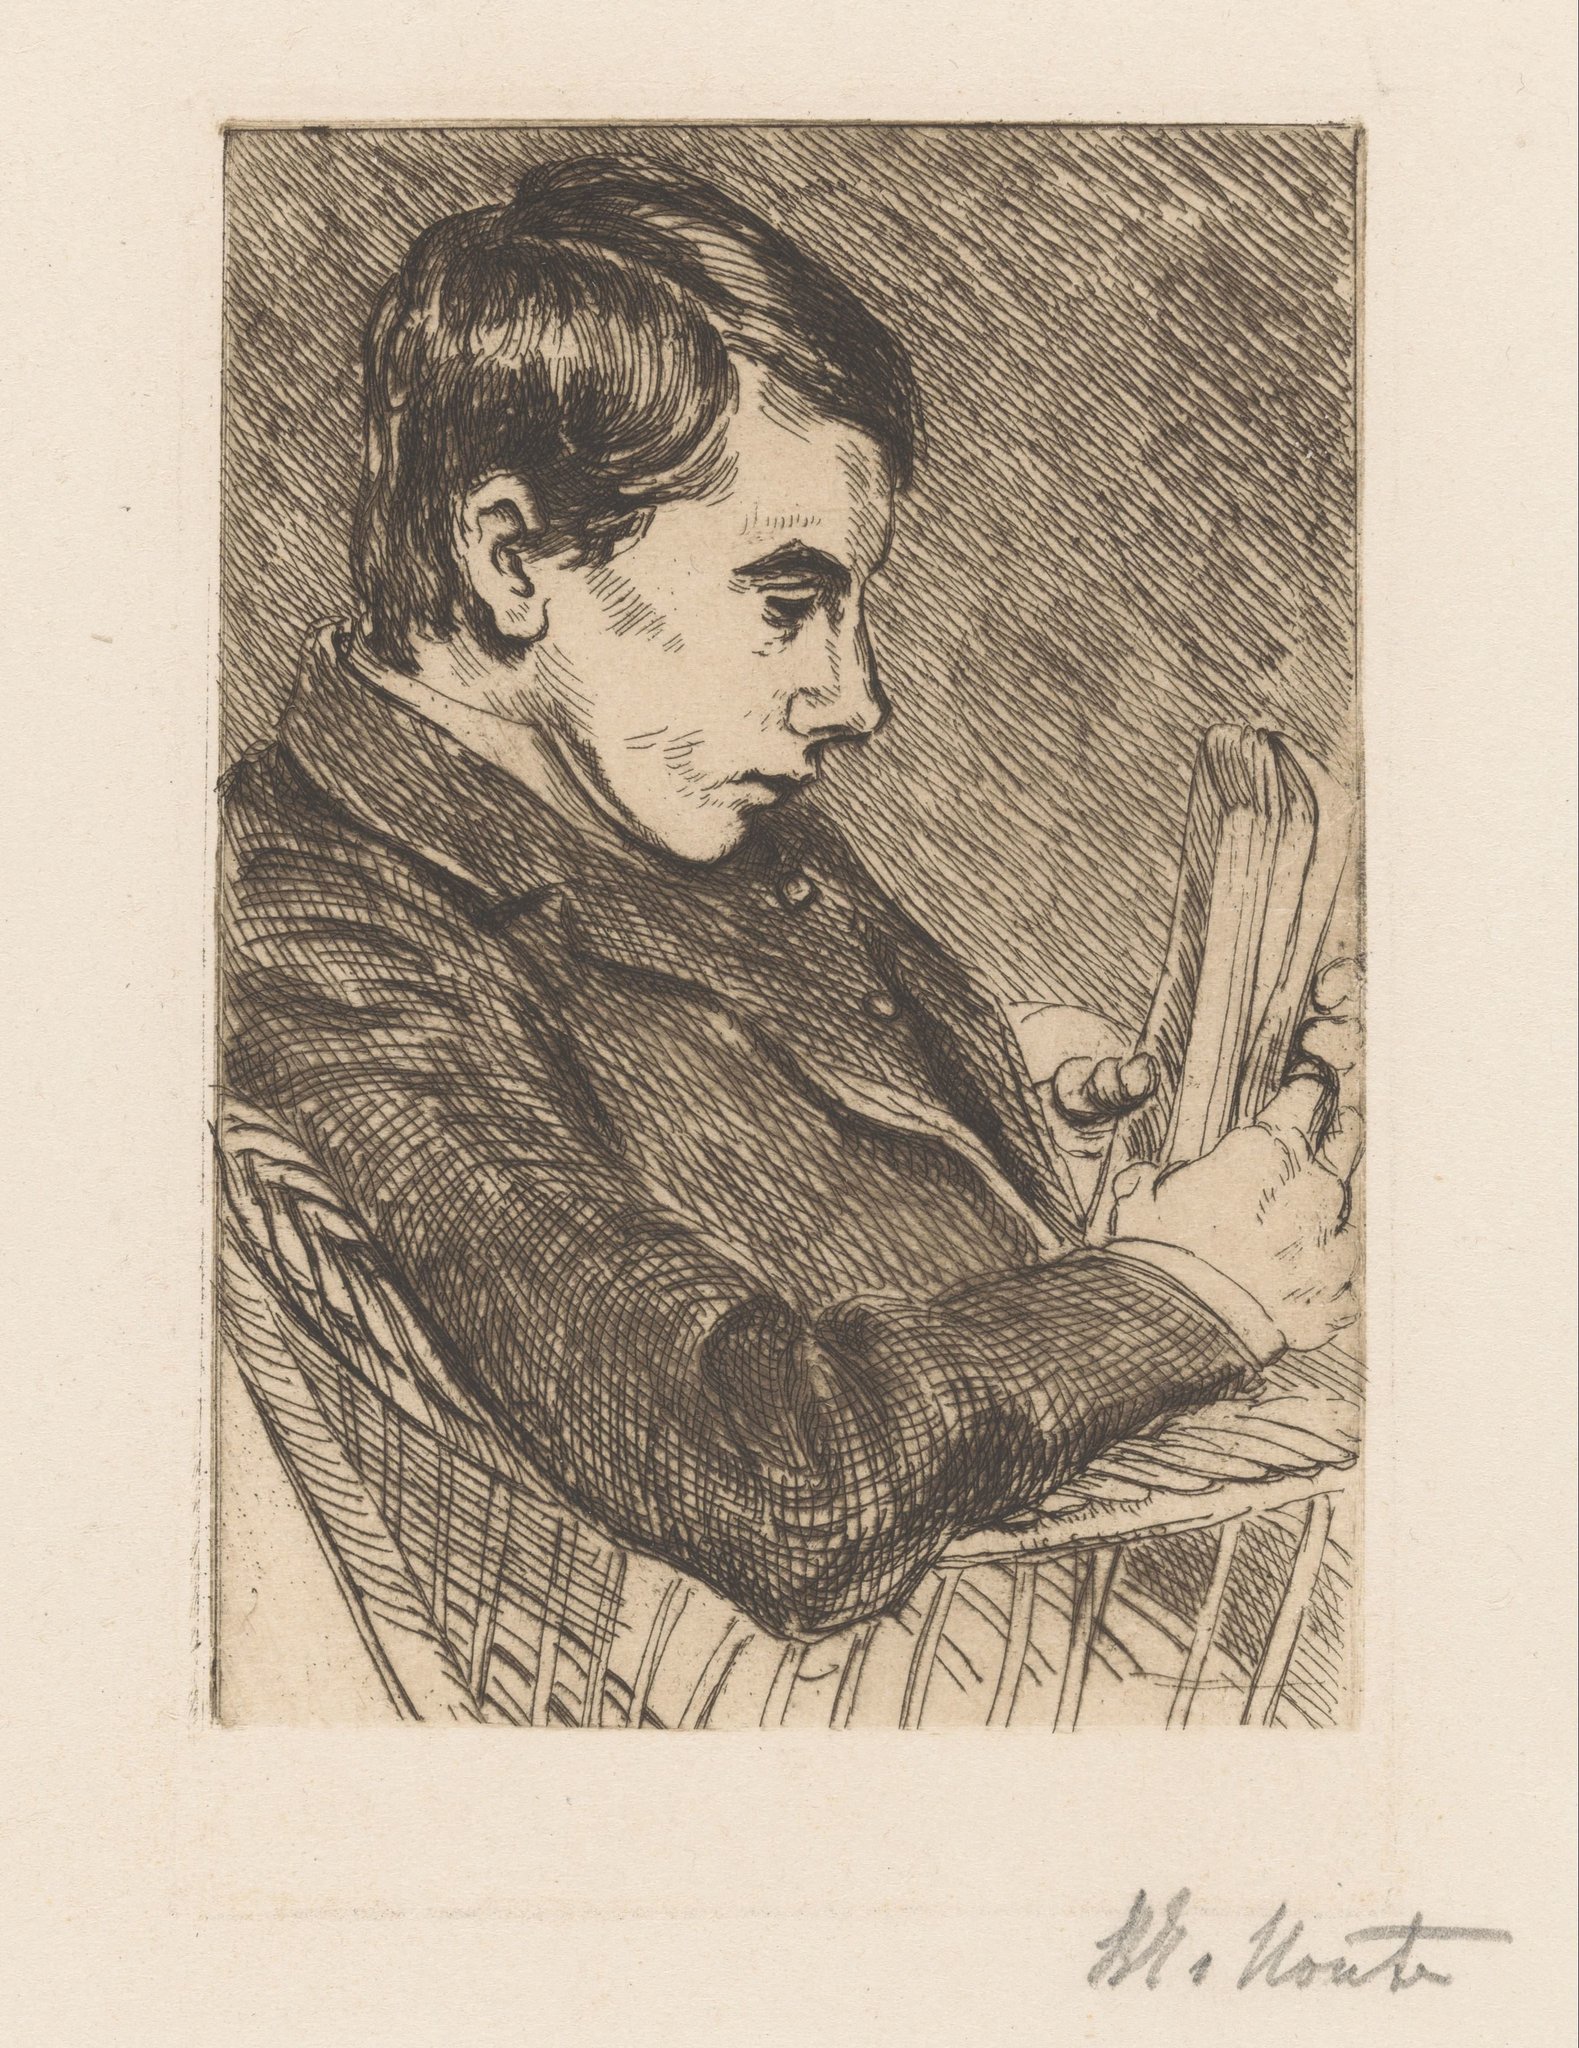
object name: print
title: Portret van H.W. Mouton met boek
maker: barbara elisabeth van houten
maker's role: draughtsman, print maker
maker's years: 1862-1950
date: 1877-1950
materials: paper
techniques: etching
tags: utrecht, engineer, reading, youth, adolescent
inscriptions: collector's mark: Lugt 2228